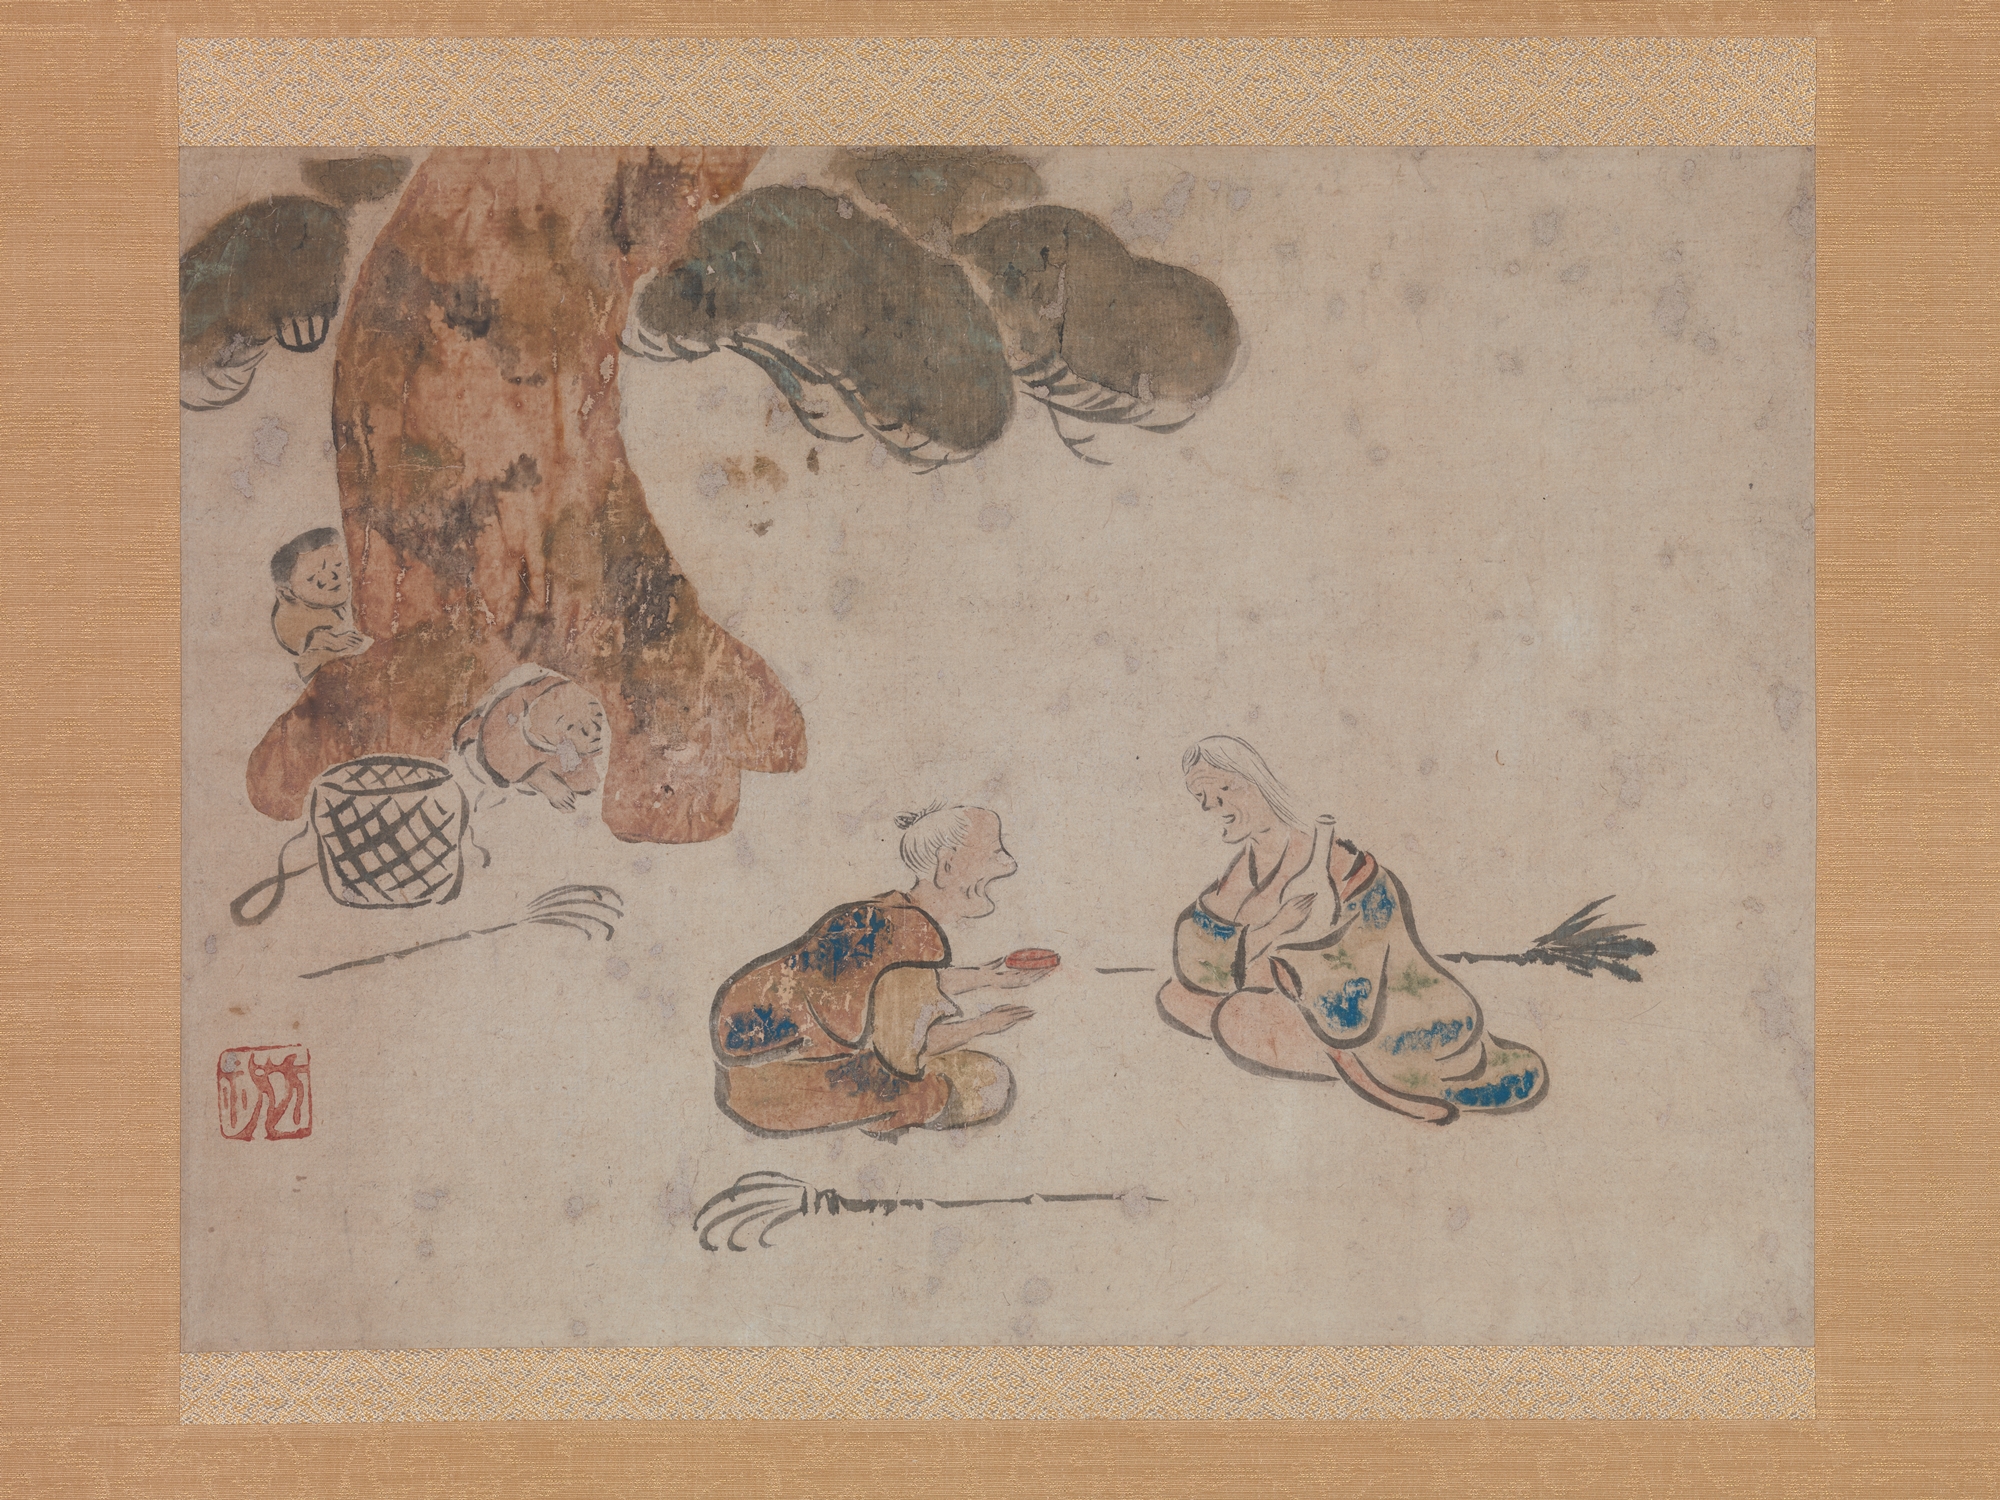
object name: hanging scroll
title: Old Man and Woman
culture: japanese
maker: ogata kōrin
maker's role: artist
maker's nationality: japanese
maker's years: 1658-1716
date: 1658-1716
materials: ink, silk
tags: men,women,trees